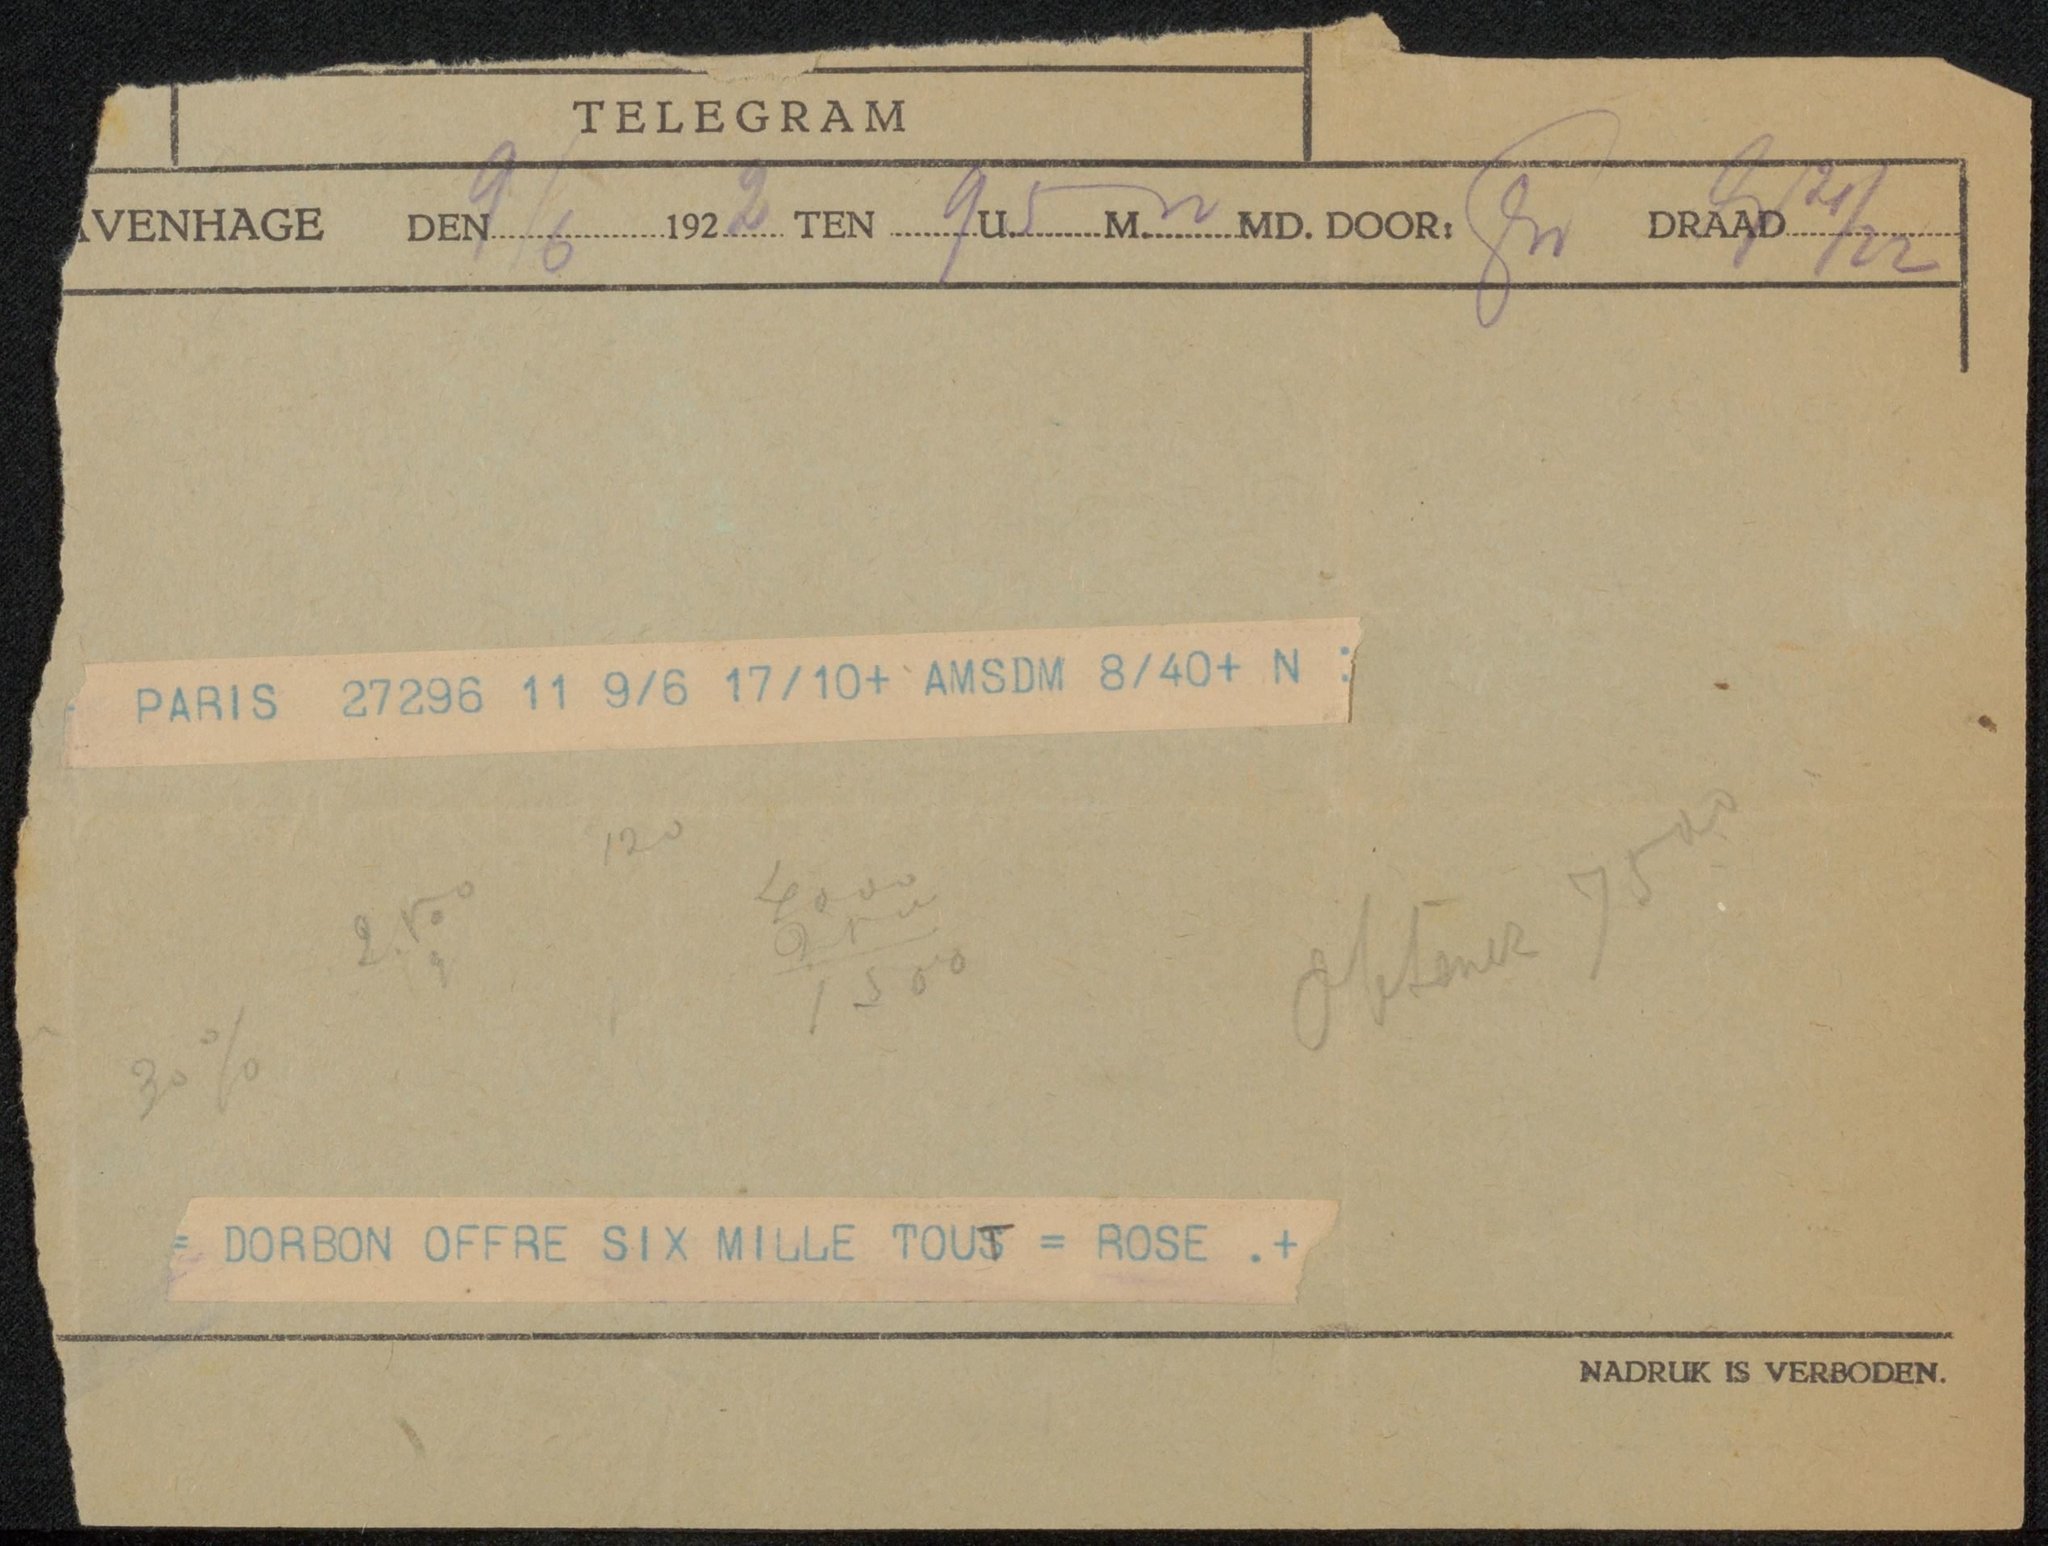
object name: telegram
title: Telegram aan Philip Zilcken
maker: rose imel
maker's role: draughtsman, painter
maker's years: 1901-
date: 1922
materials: paper, pencil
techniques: printing, typewriting, writing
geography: paris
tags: paris, publisher, the hague, painter, philip zilcken, money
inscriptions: collector's mark: ‘RPK’